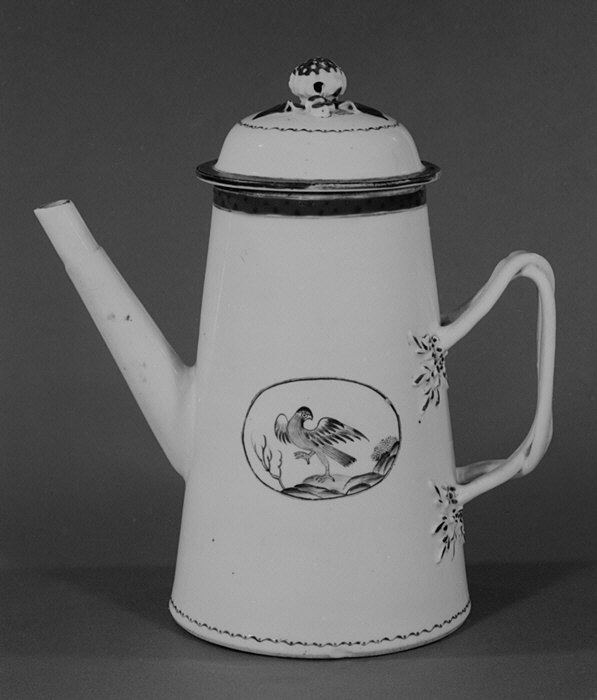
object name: coffeepot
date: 1701-1800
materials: hard paste porcelain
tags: birds